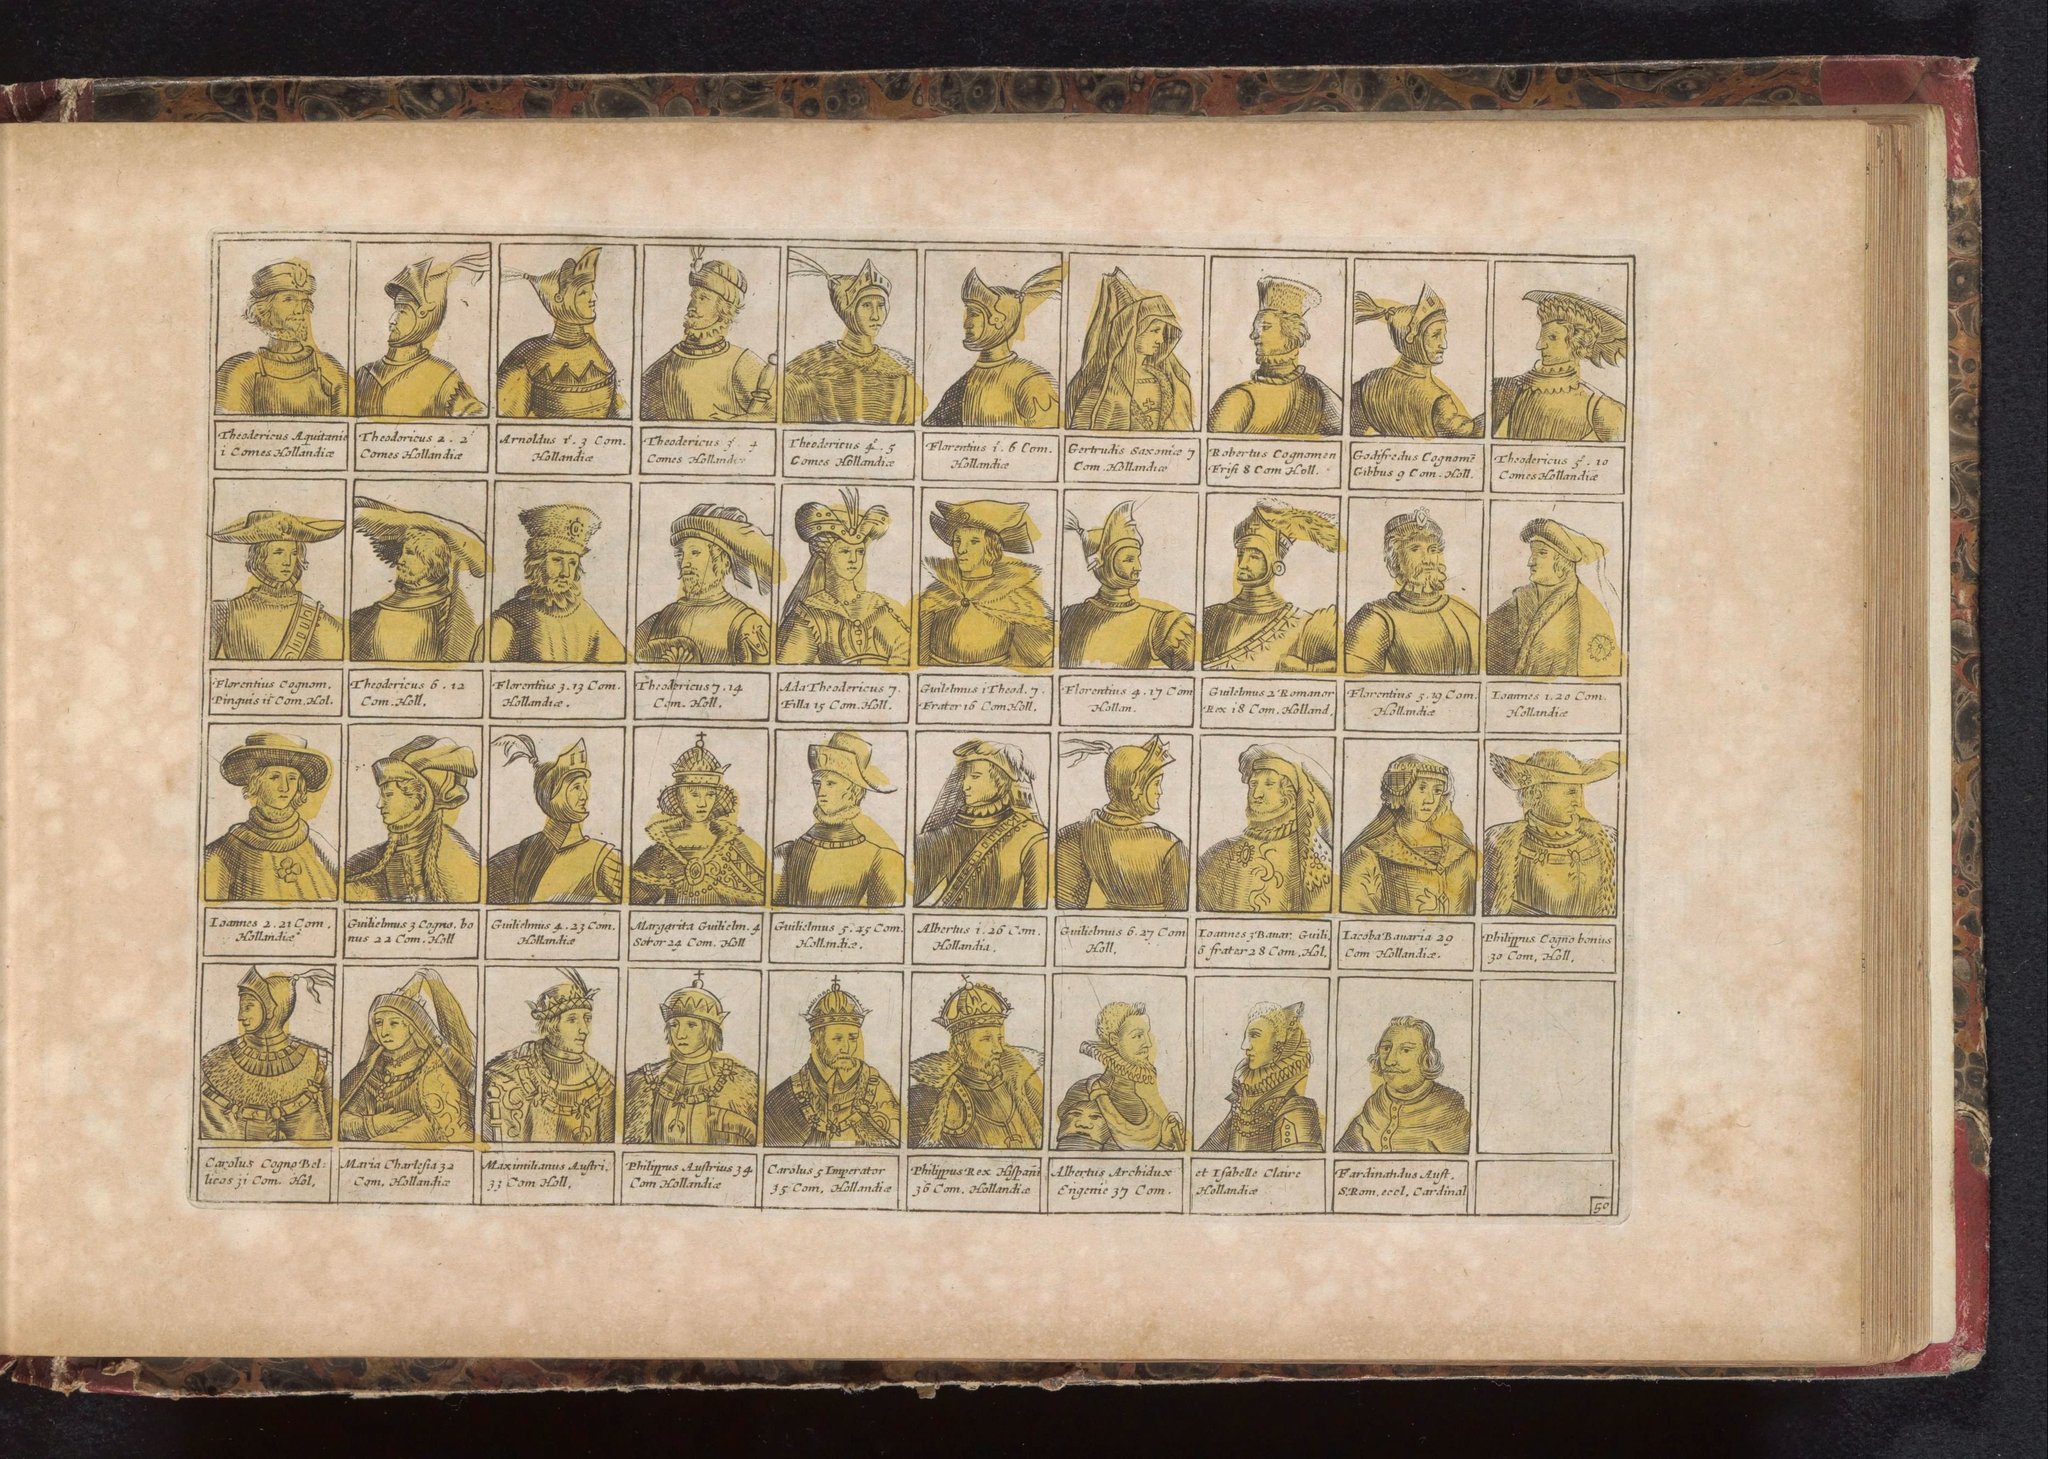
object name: print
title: Portretten van de graven van Holland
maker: Anonymous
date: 1700-1702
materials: paper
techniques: engraving, hand coloring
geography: northern netherlands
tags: holland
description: Blad met veertig portretten van de graven van Holland. Het laatse vakje opengelaten. Onderdeel van een atlas met 223 kaarten van landen en steden en oorlogstaferelen in Europa in de periode ca. 1690-1735.